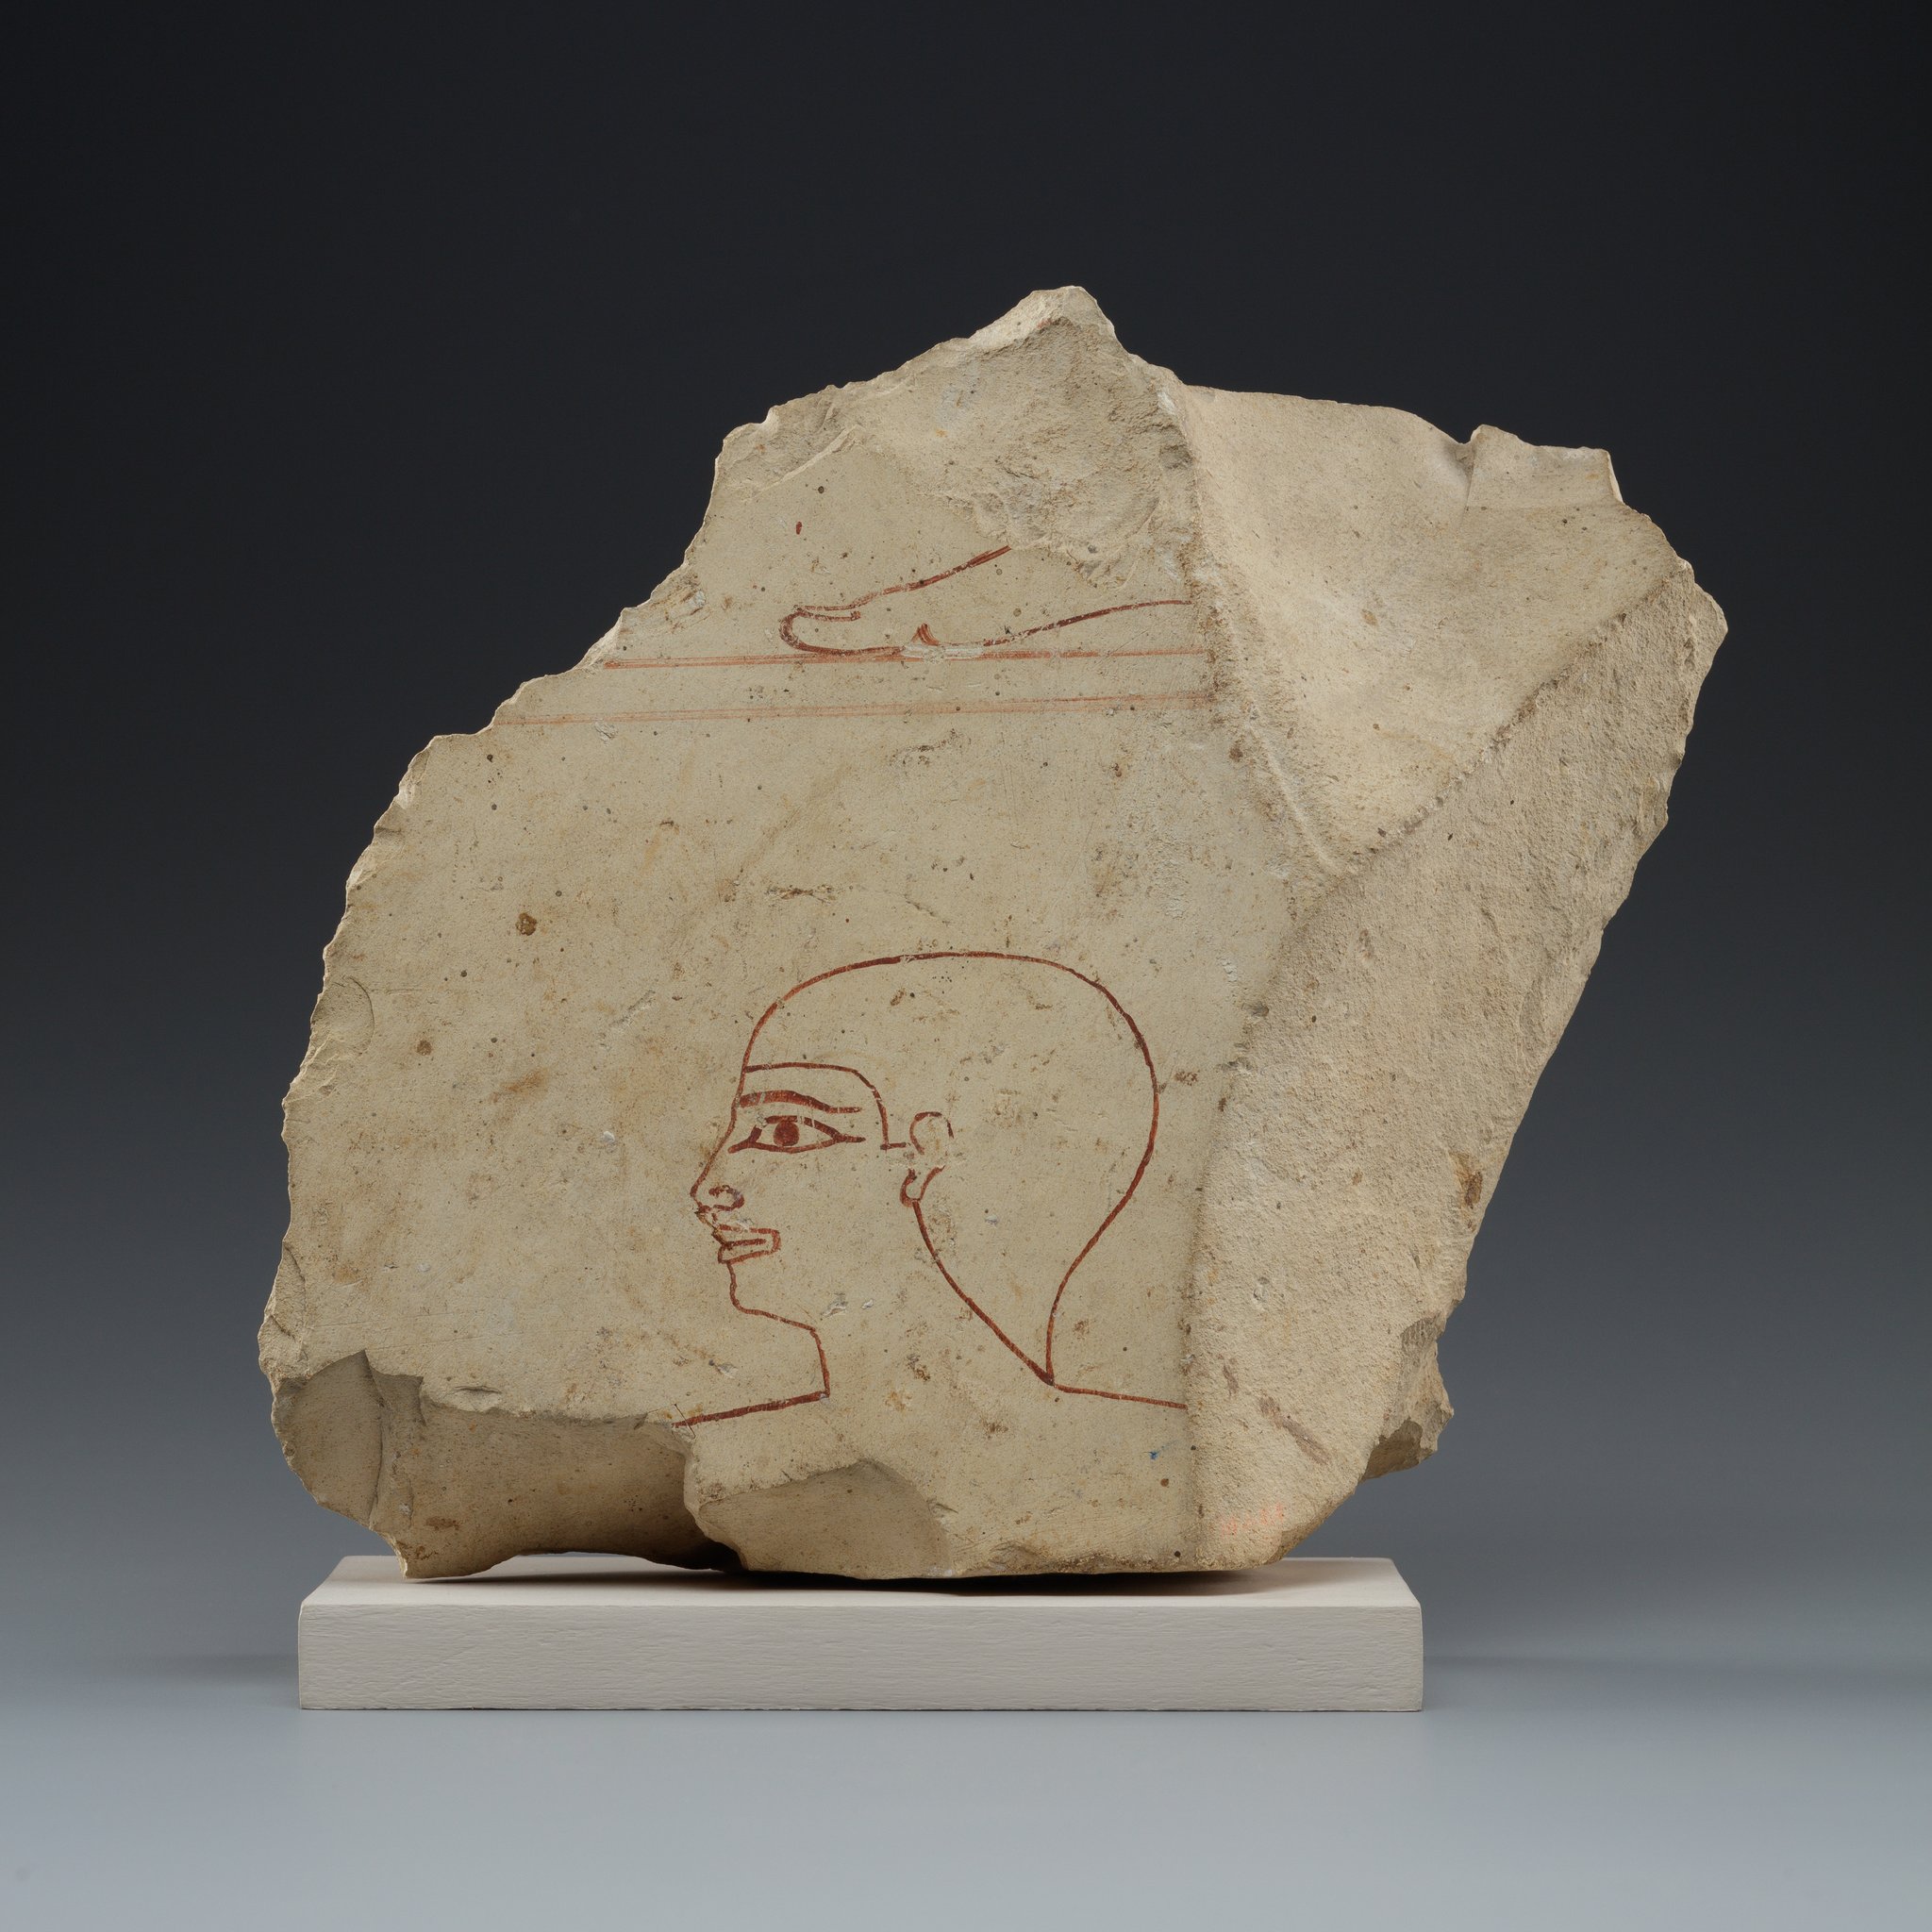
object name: relief drawing, head, foot, sebeknakhte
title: Preliminary drawing of a head and foot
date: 2124-1504 BCE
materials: ink, limestone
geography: egypt